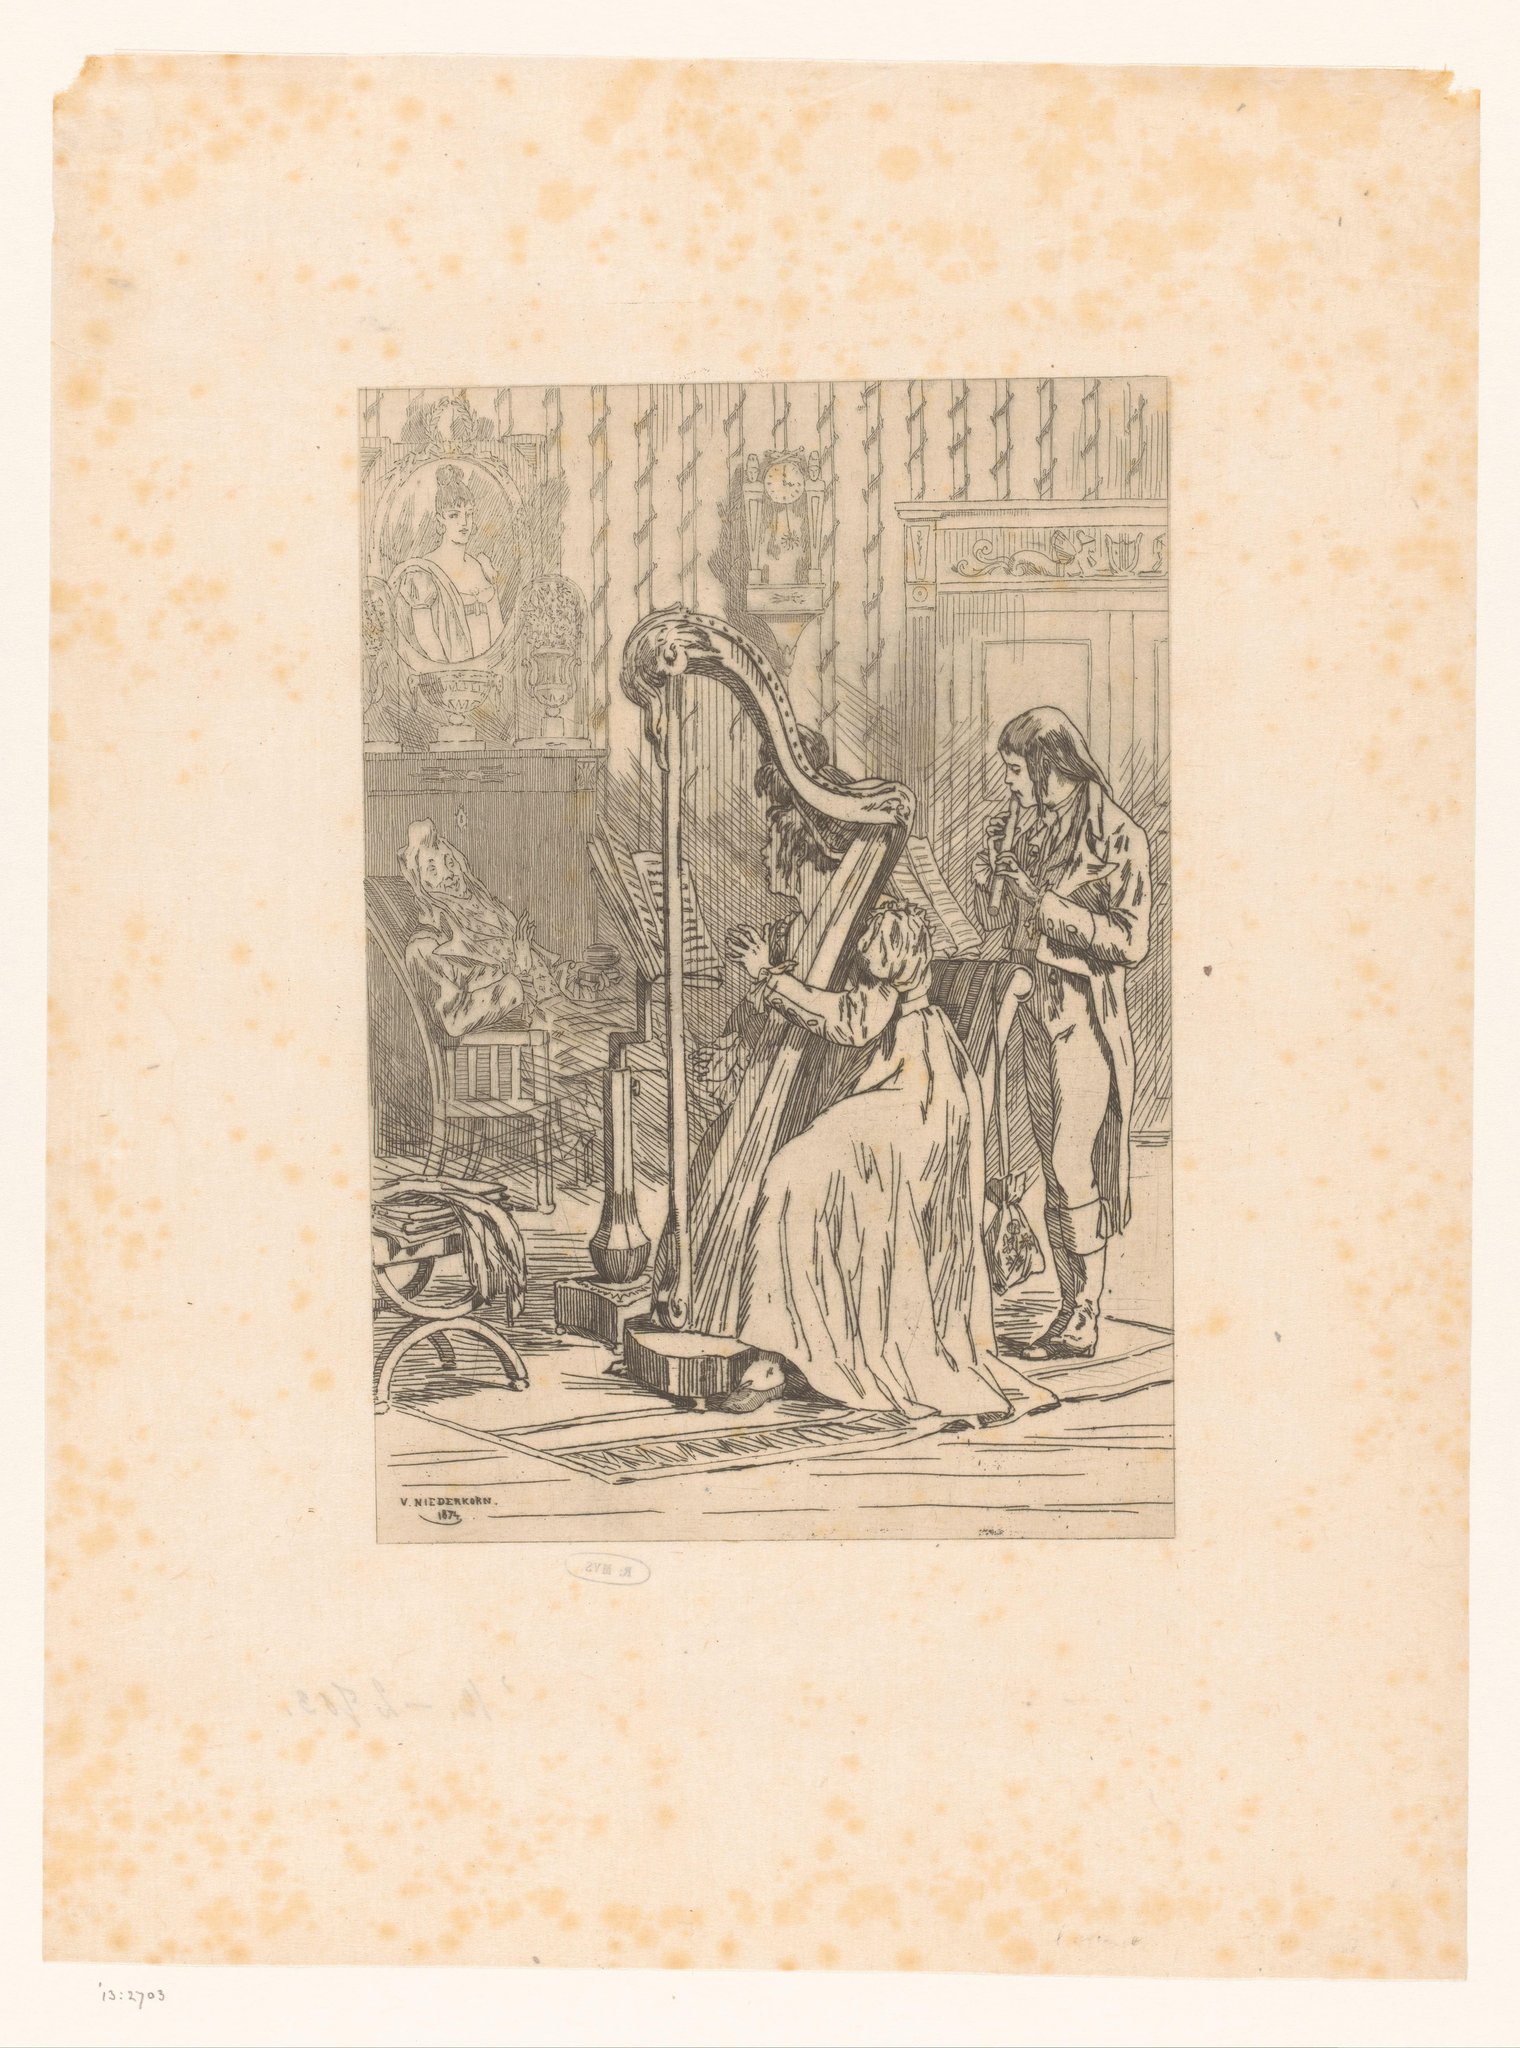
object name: print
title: L'ariette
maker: félicien rops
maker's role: draughtsman, print maker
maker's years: 1833-1898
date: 1874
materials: paper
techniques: etching, intaglio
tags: instrumental and vocal music together, transverse flute, harp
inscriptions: collector's mark: Lugt 2228